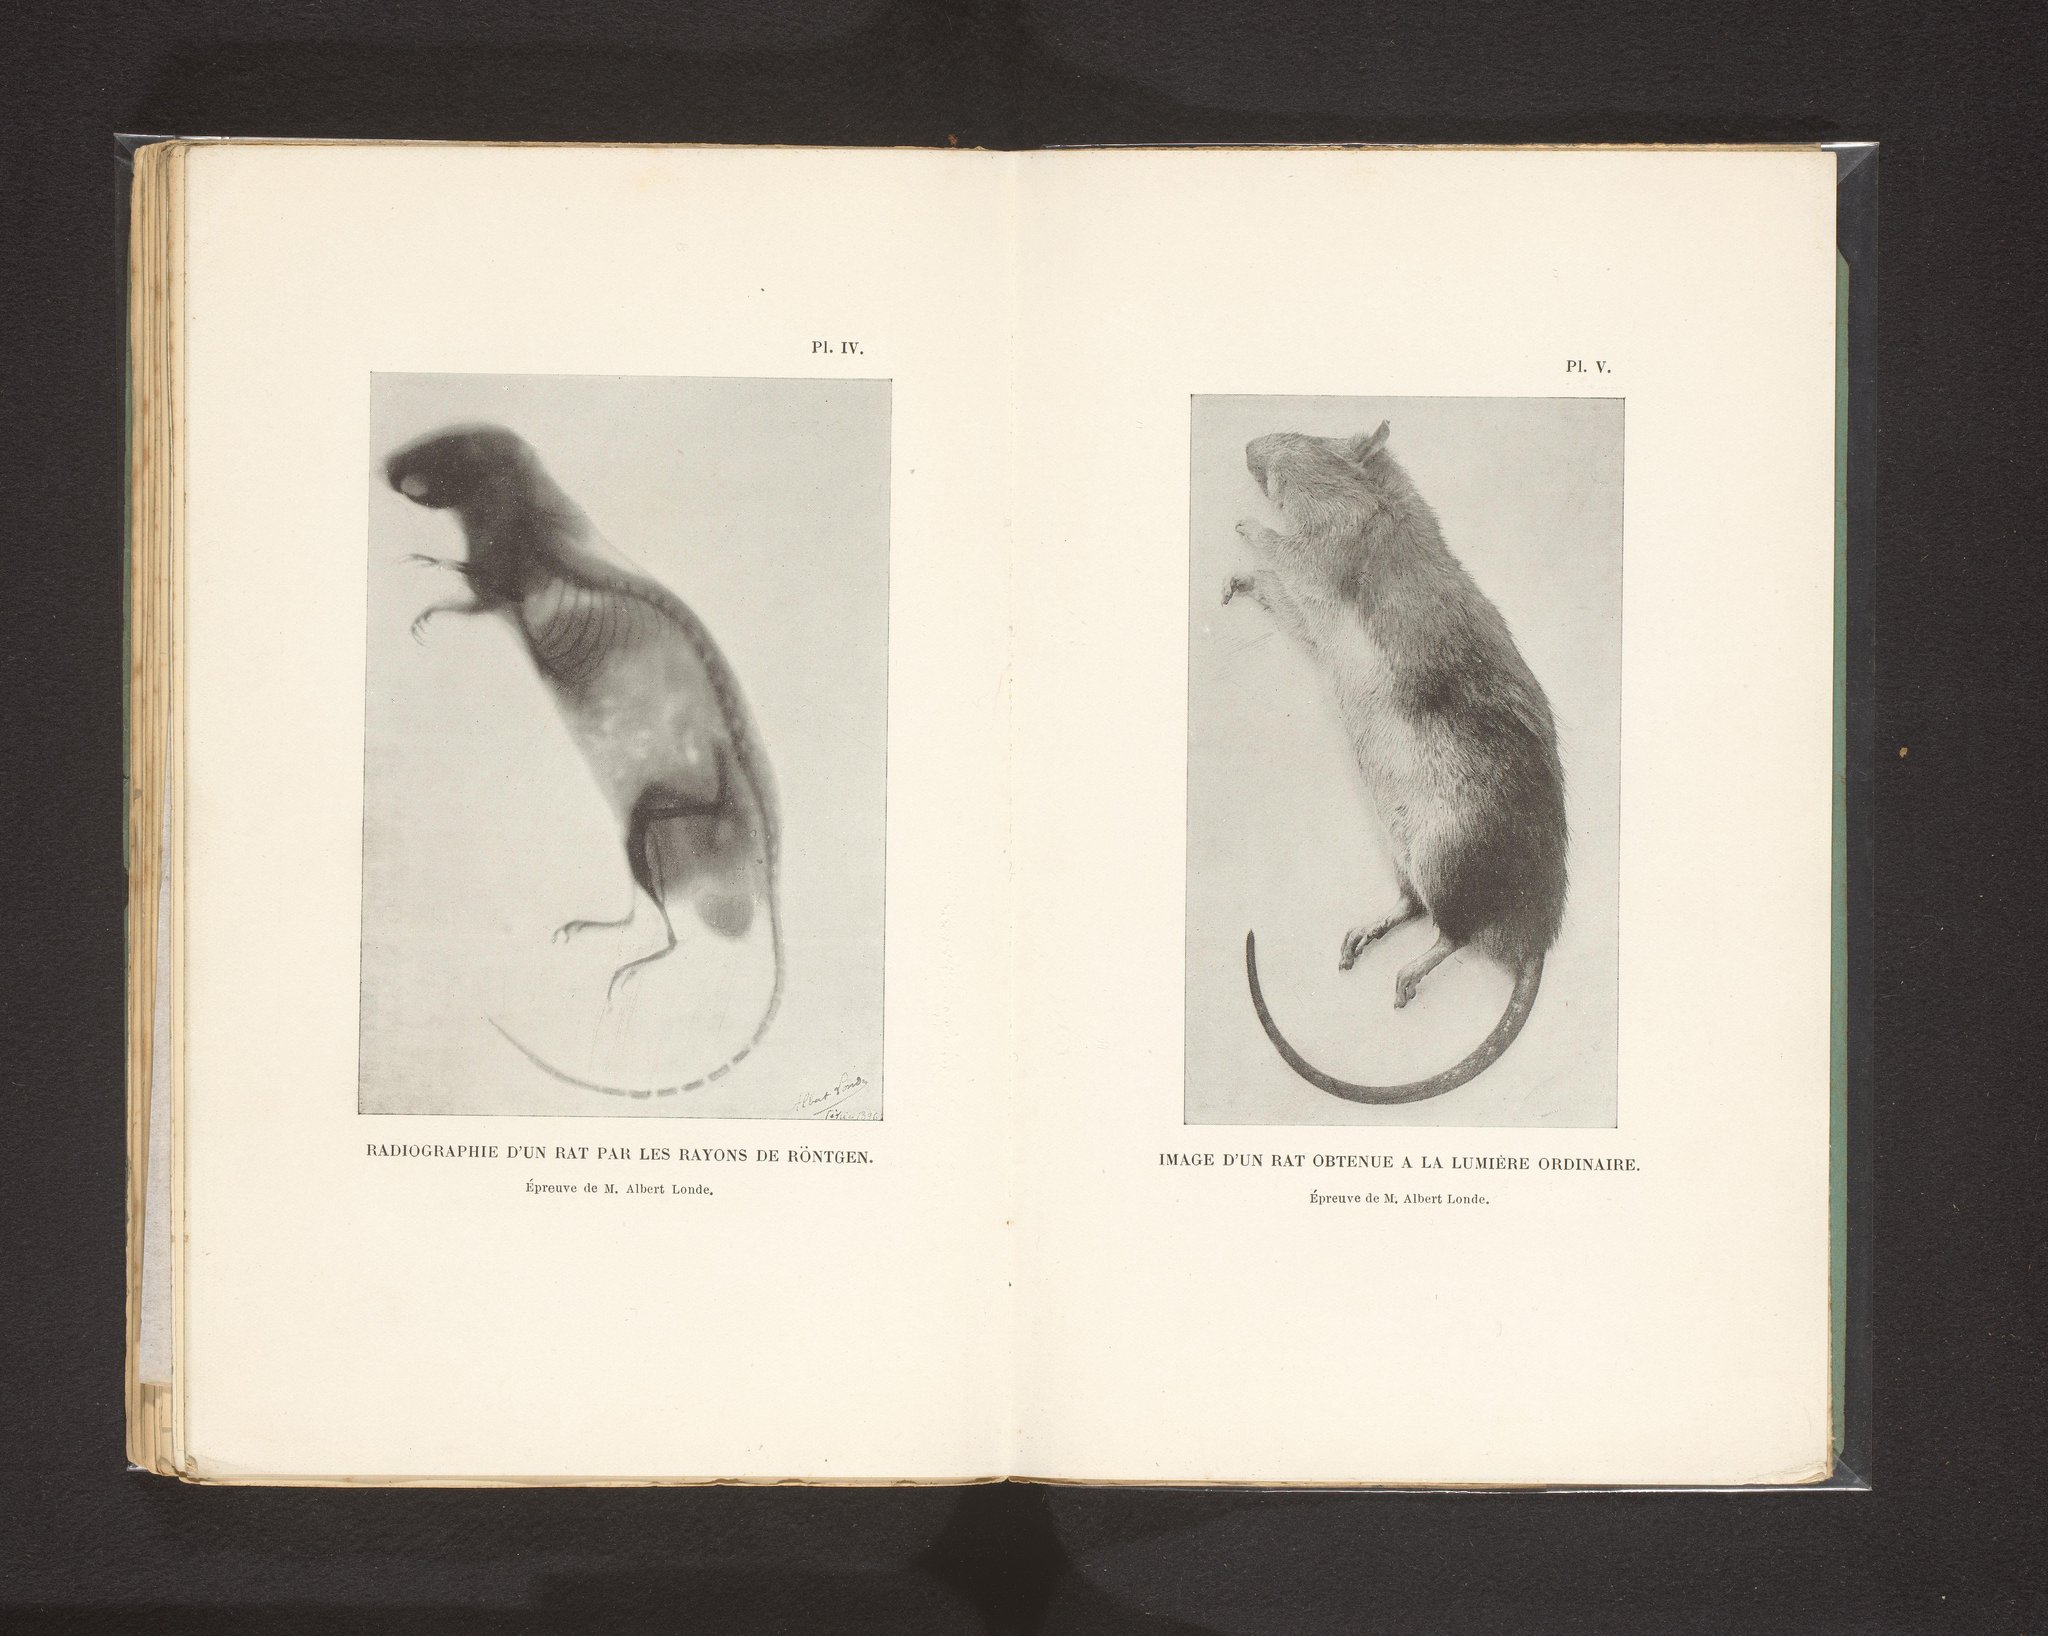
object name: photomechanical print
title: Image d'un rat obtenue al la lumière ordinaire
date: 1886-1896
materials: paper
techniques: autotype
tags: rodents: rat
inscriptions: number: ‘Pl. V.’